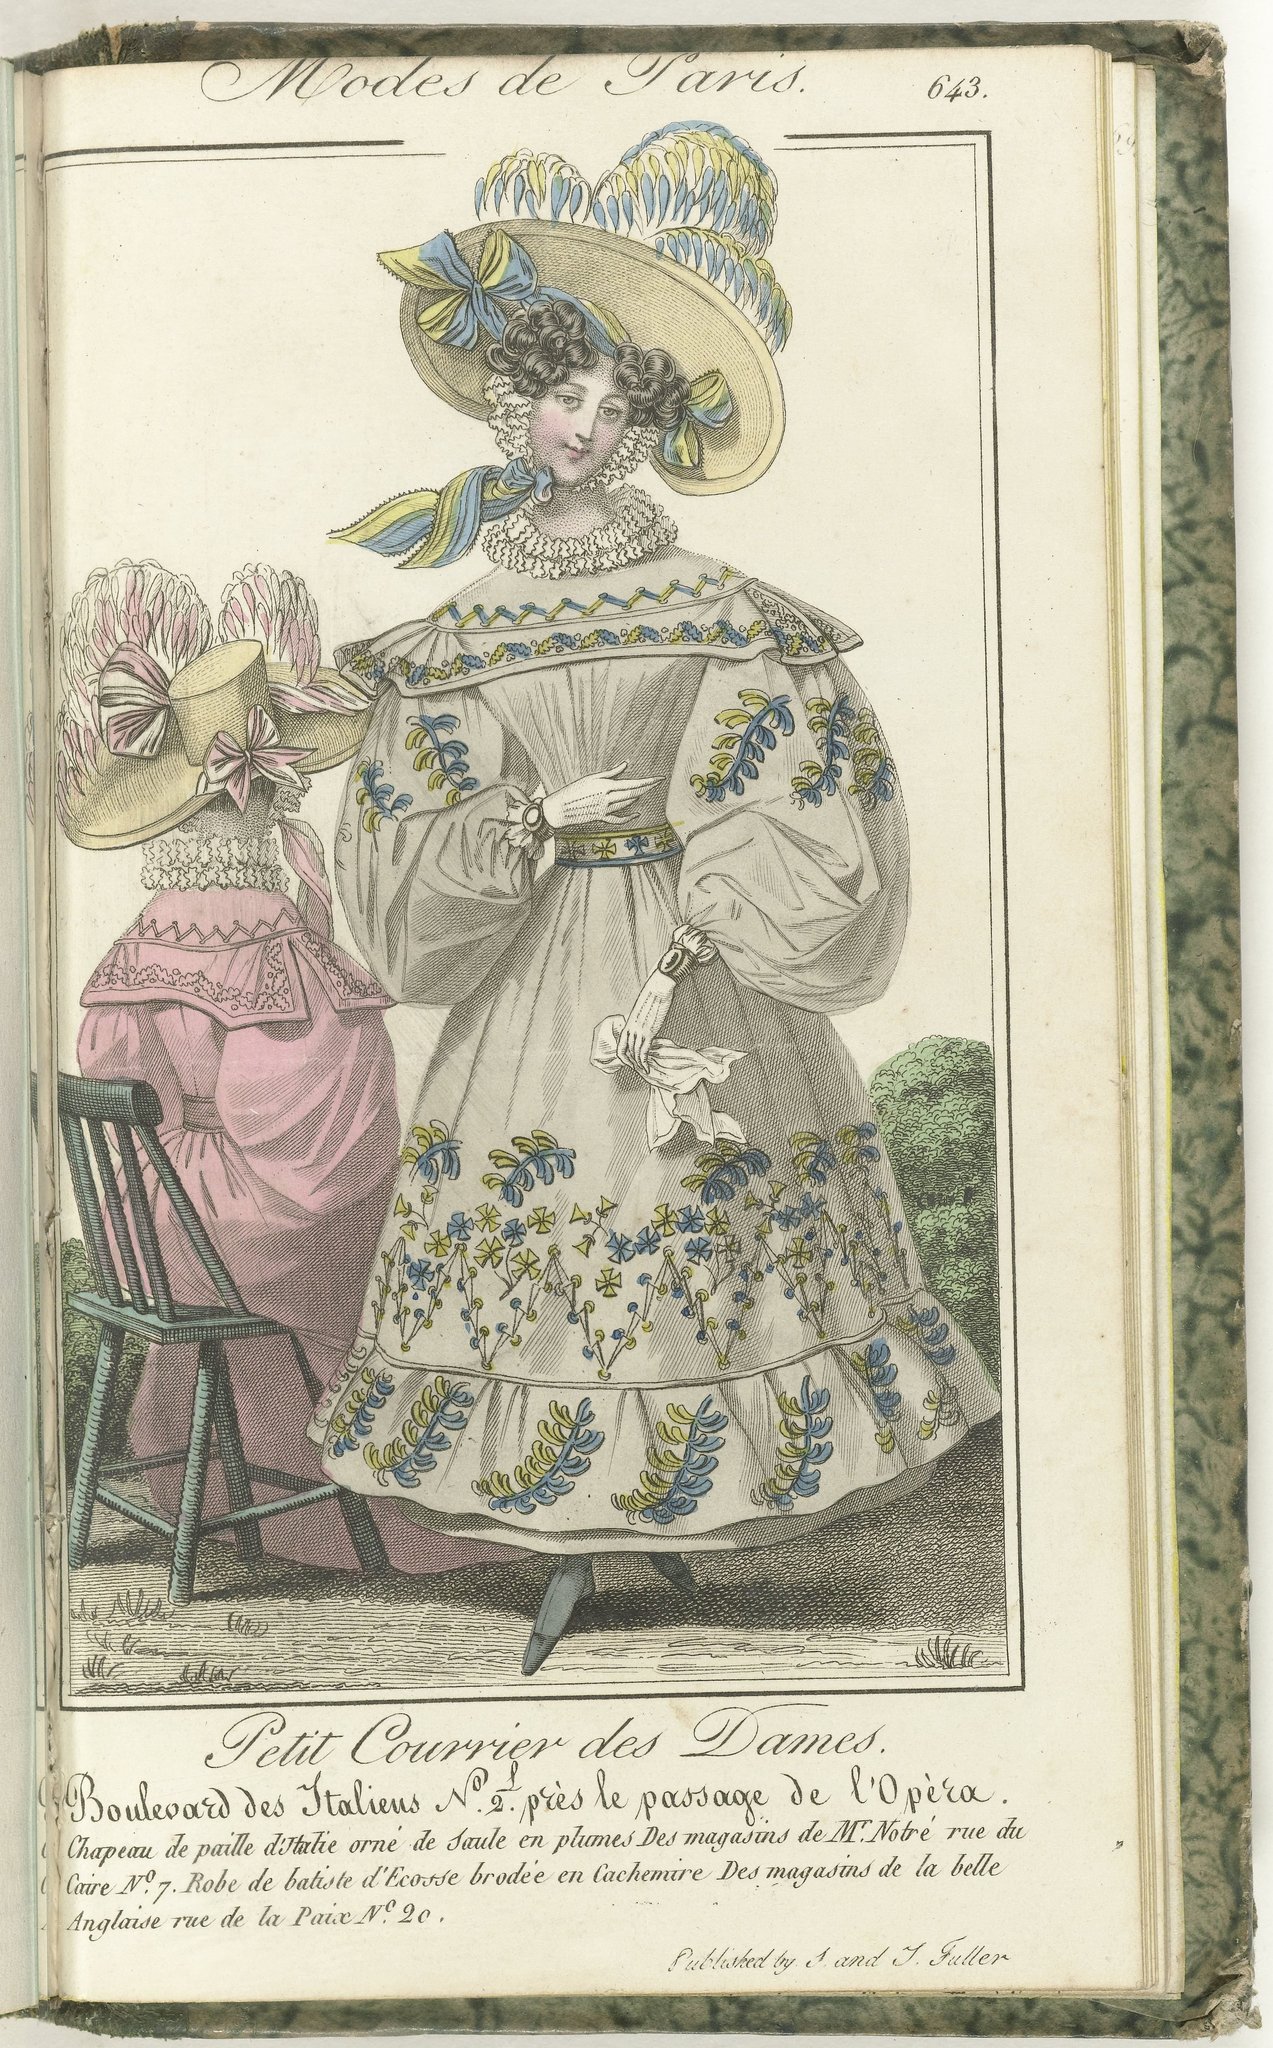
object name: fashion print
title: Petit Courrier des Dames, 5 juin 1829, No. 643 : Chapeau de paille d'Italie...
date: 1829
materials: paper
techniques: engraving, hand coloring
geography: paris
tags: handkerchief (+ women's clothes), embroidery (ornamentation) (+ women's clothes), fashion plates, head-gear: hat (+ women's clothes), dress, gown (+ women's clothes)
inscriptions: title: ‘Modes de Paris.’, caption: ‘Chapeau de paille d'Italie orné de saule en plumes Des magasins de M.r Notré rue du Caire No. 7. robe de batiste d'Ecosse brodée en cachemire Des magasins de la belle Anglaise rue de la Paix No. 20.’, inscription: ‘Published by S. and J. Fuller’, title: ‘Petit Courrier des Dames.’, address: ‘Boulevard des Italiens No.2 près le passage de l'Opèra.’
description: Staande vrouw gekleed in een japon van 'batiste d'Ecosse' (batist) geborduurd met kasjmier. Op het hoofd een hoed van 'paille d'Italie' versierd met een wilgentak, uit de winkels van Notré. Zittende figuur, op de rug gezien, in eenzelfde japon. Prent uit het modetijdschrift Petit Courrier des Dames (1821-1868). Ingebonden (met enkele pag. Le Journal des Dames et des Modes). 15 Januari 1827 t/m 20 maart 1830. Incompleet.